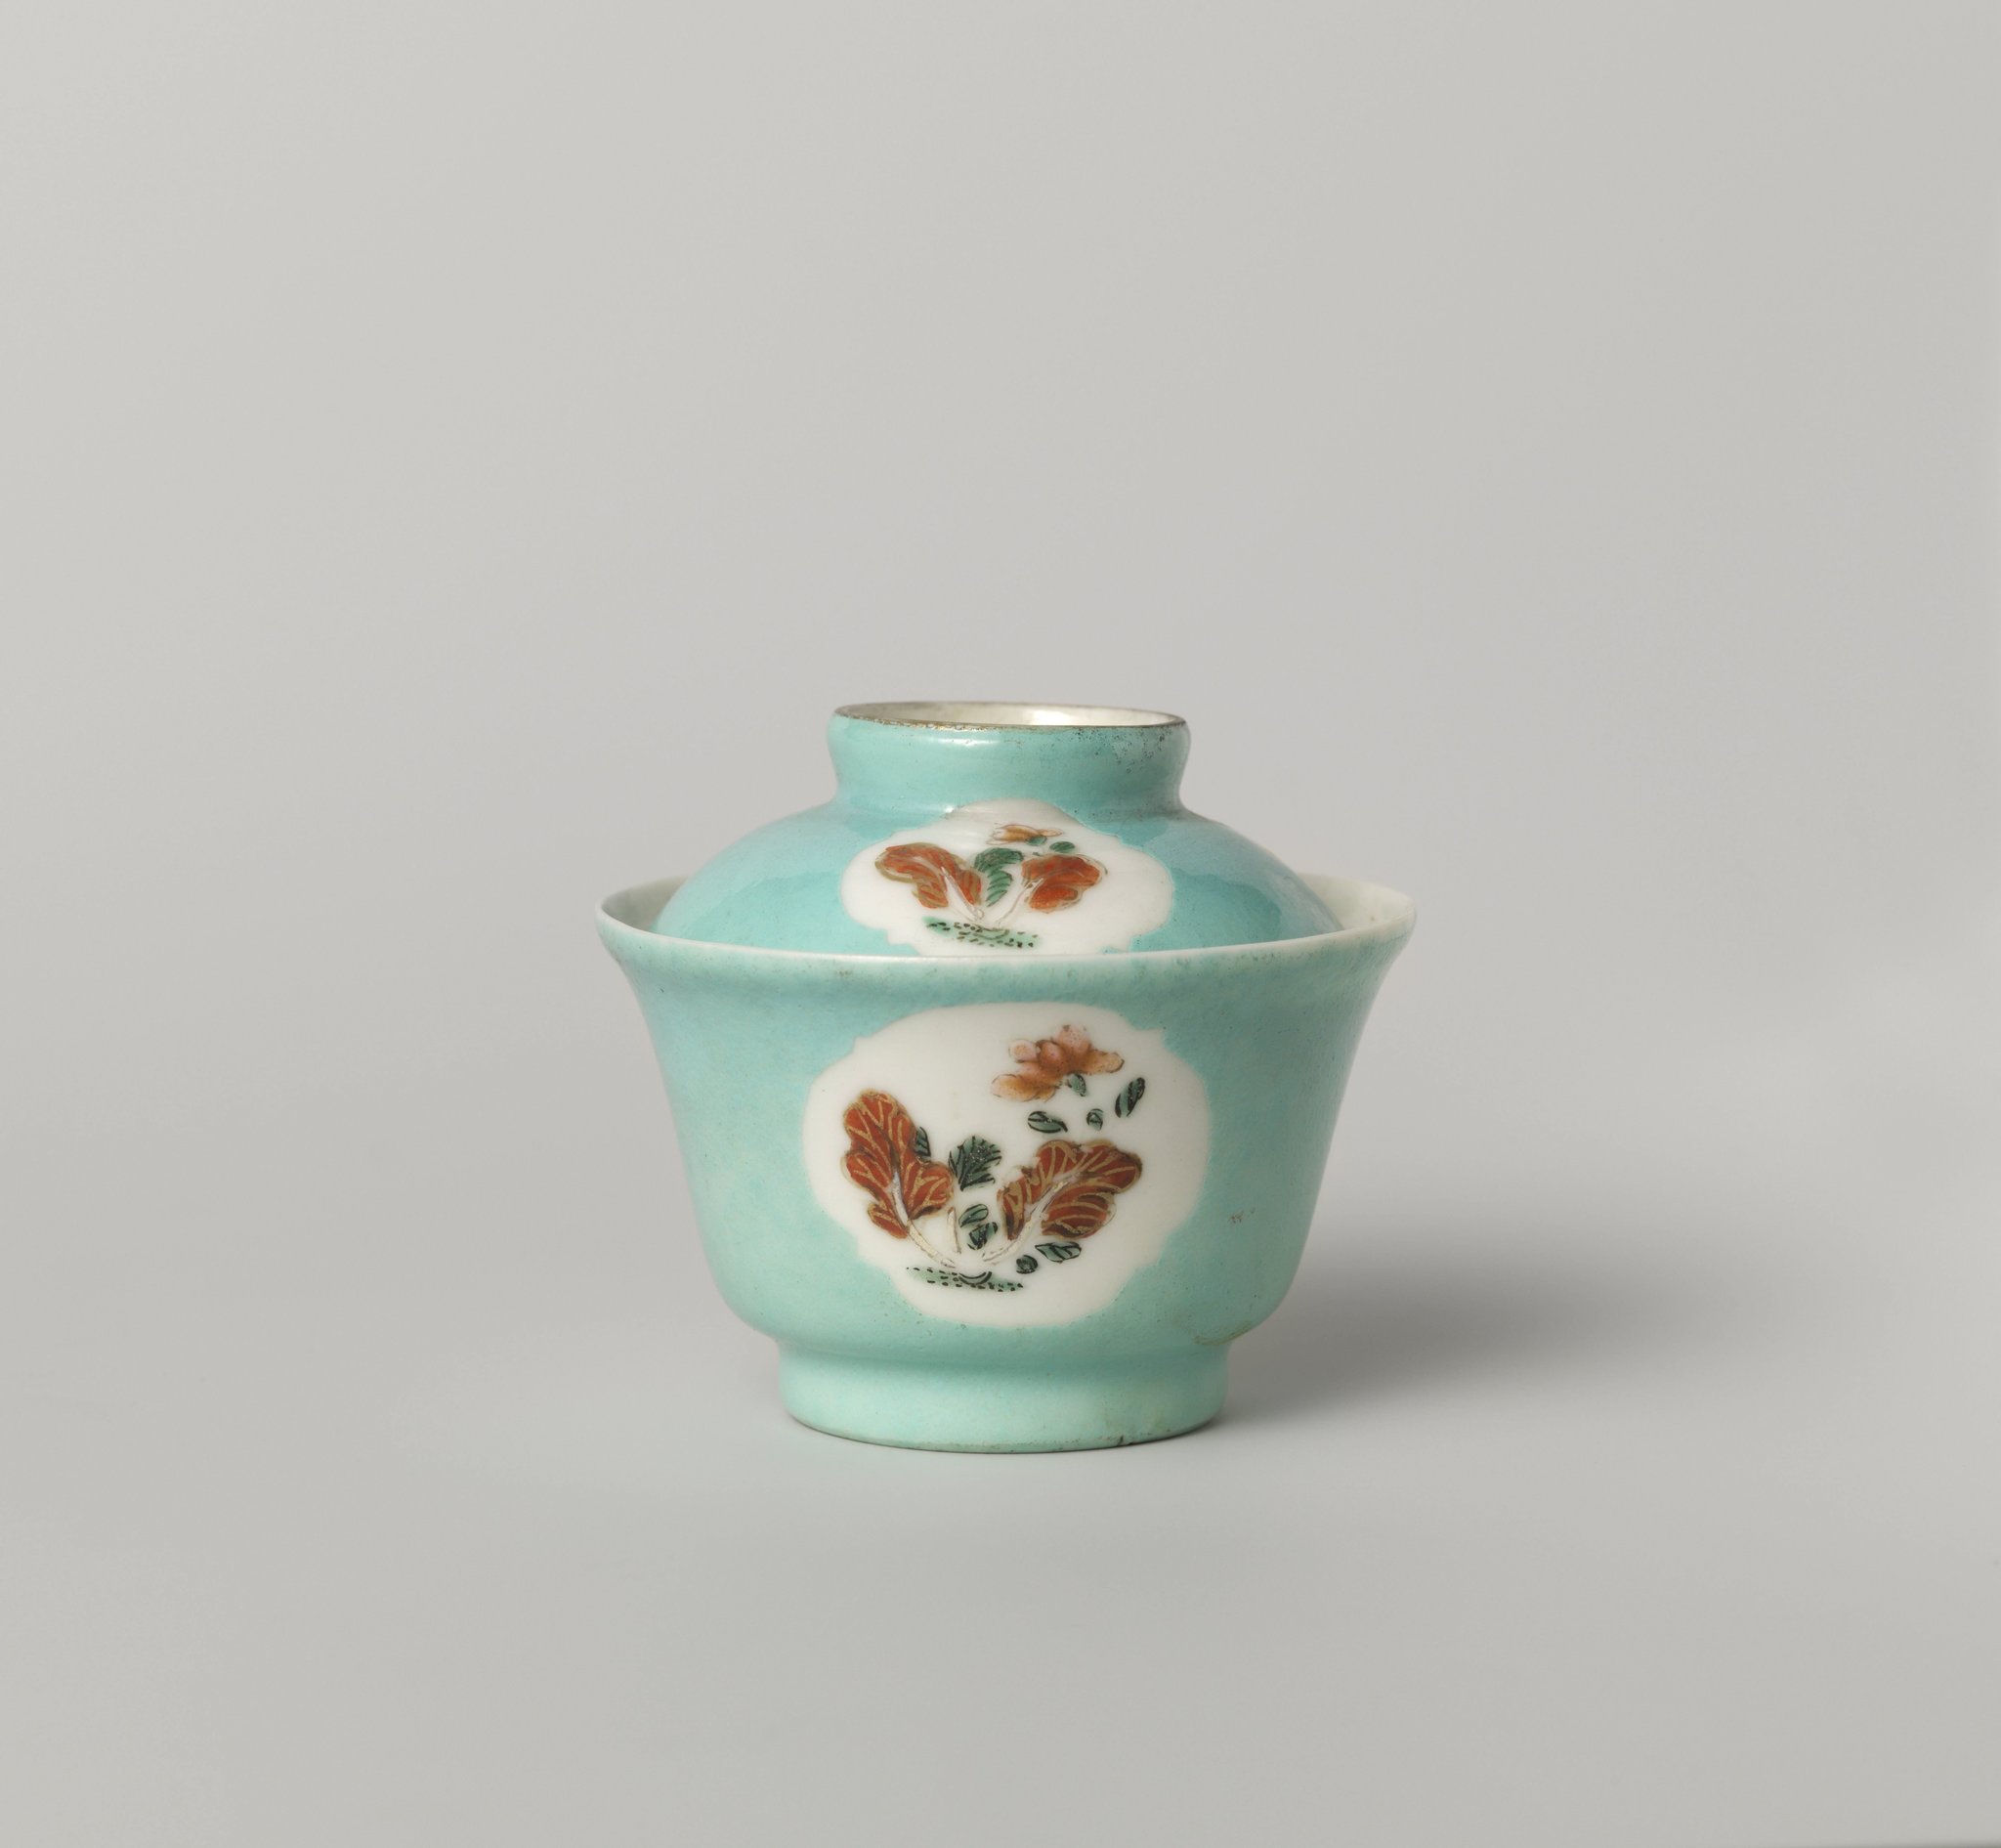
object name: cup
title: Bell-shaped covered cup with flowering plants in shaped panels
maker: Anonymous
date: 1760-1780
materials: glaze, gold, paint, porcelain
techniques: firing, gilding, turning, vitrification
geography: china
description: Klokvormige kop van porselein, bedekt met een turquoise glazuur en berschilderd in blauw, rood, roze, groen, zwart en goud. Bedekt met een turquoise glazuur met hierin uitgespaard in het centrum een geschulpt medaillon met plant, daaromheen drie uitgespaarde cartouches met bloeiende planten en een vogel op een tak afgebeeld. Famille rose.